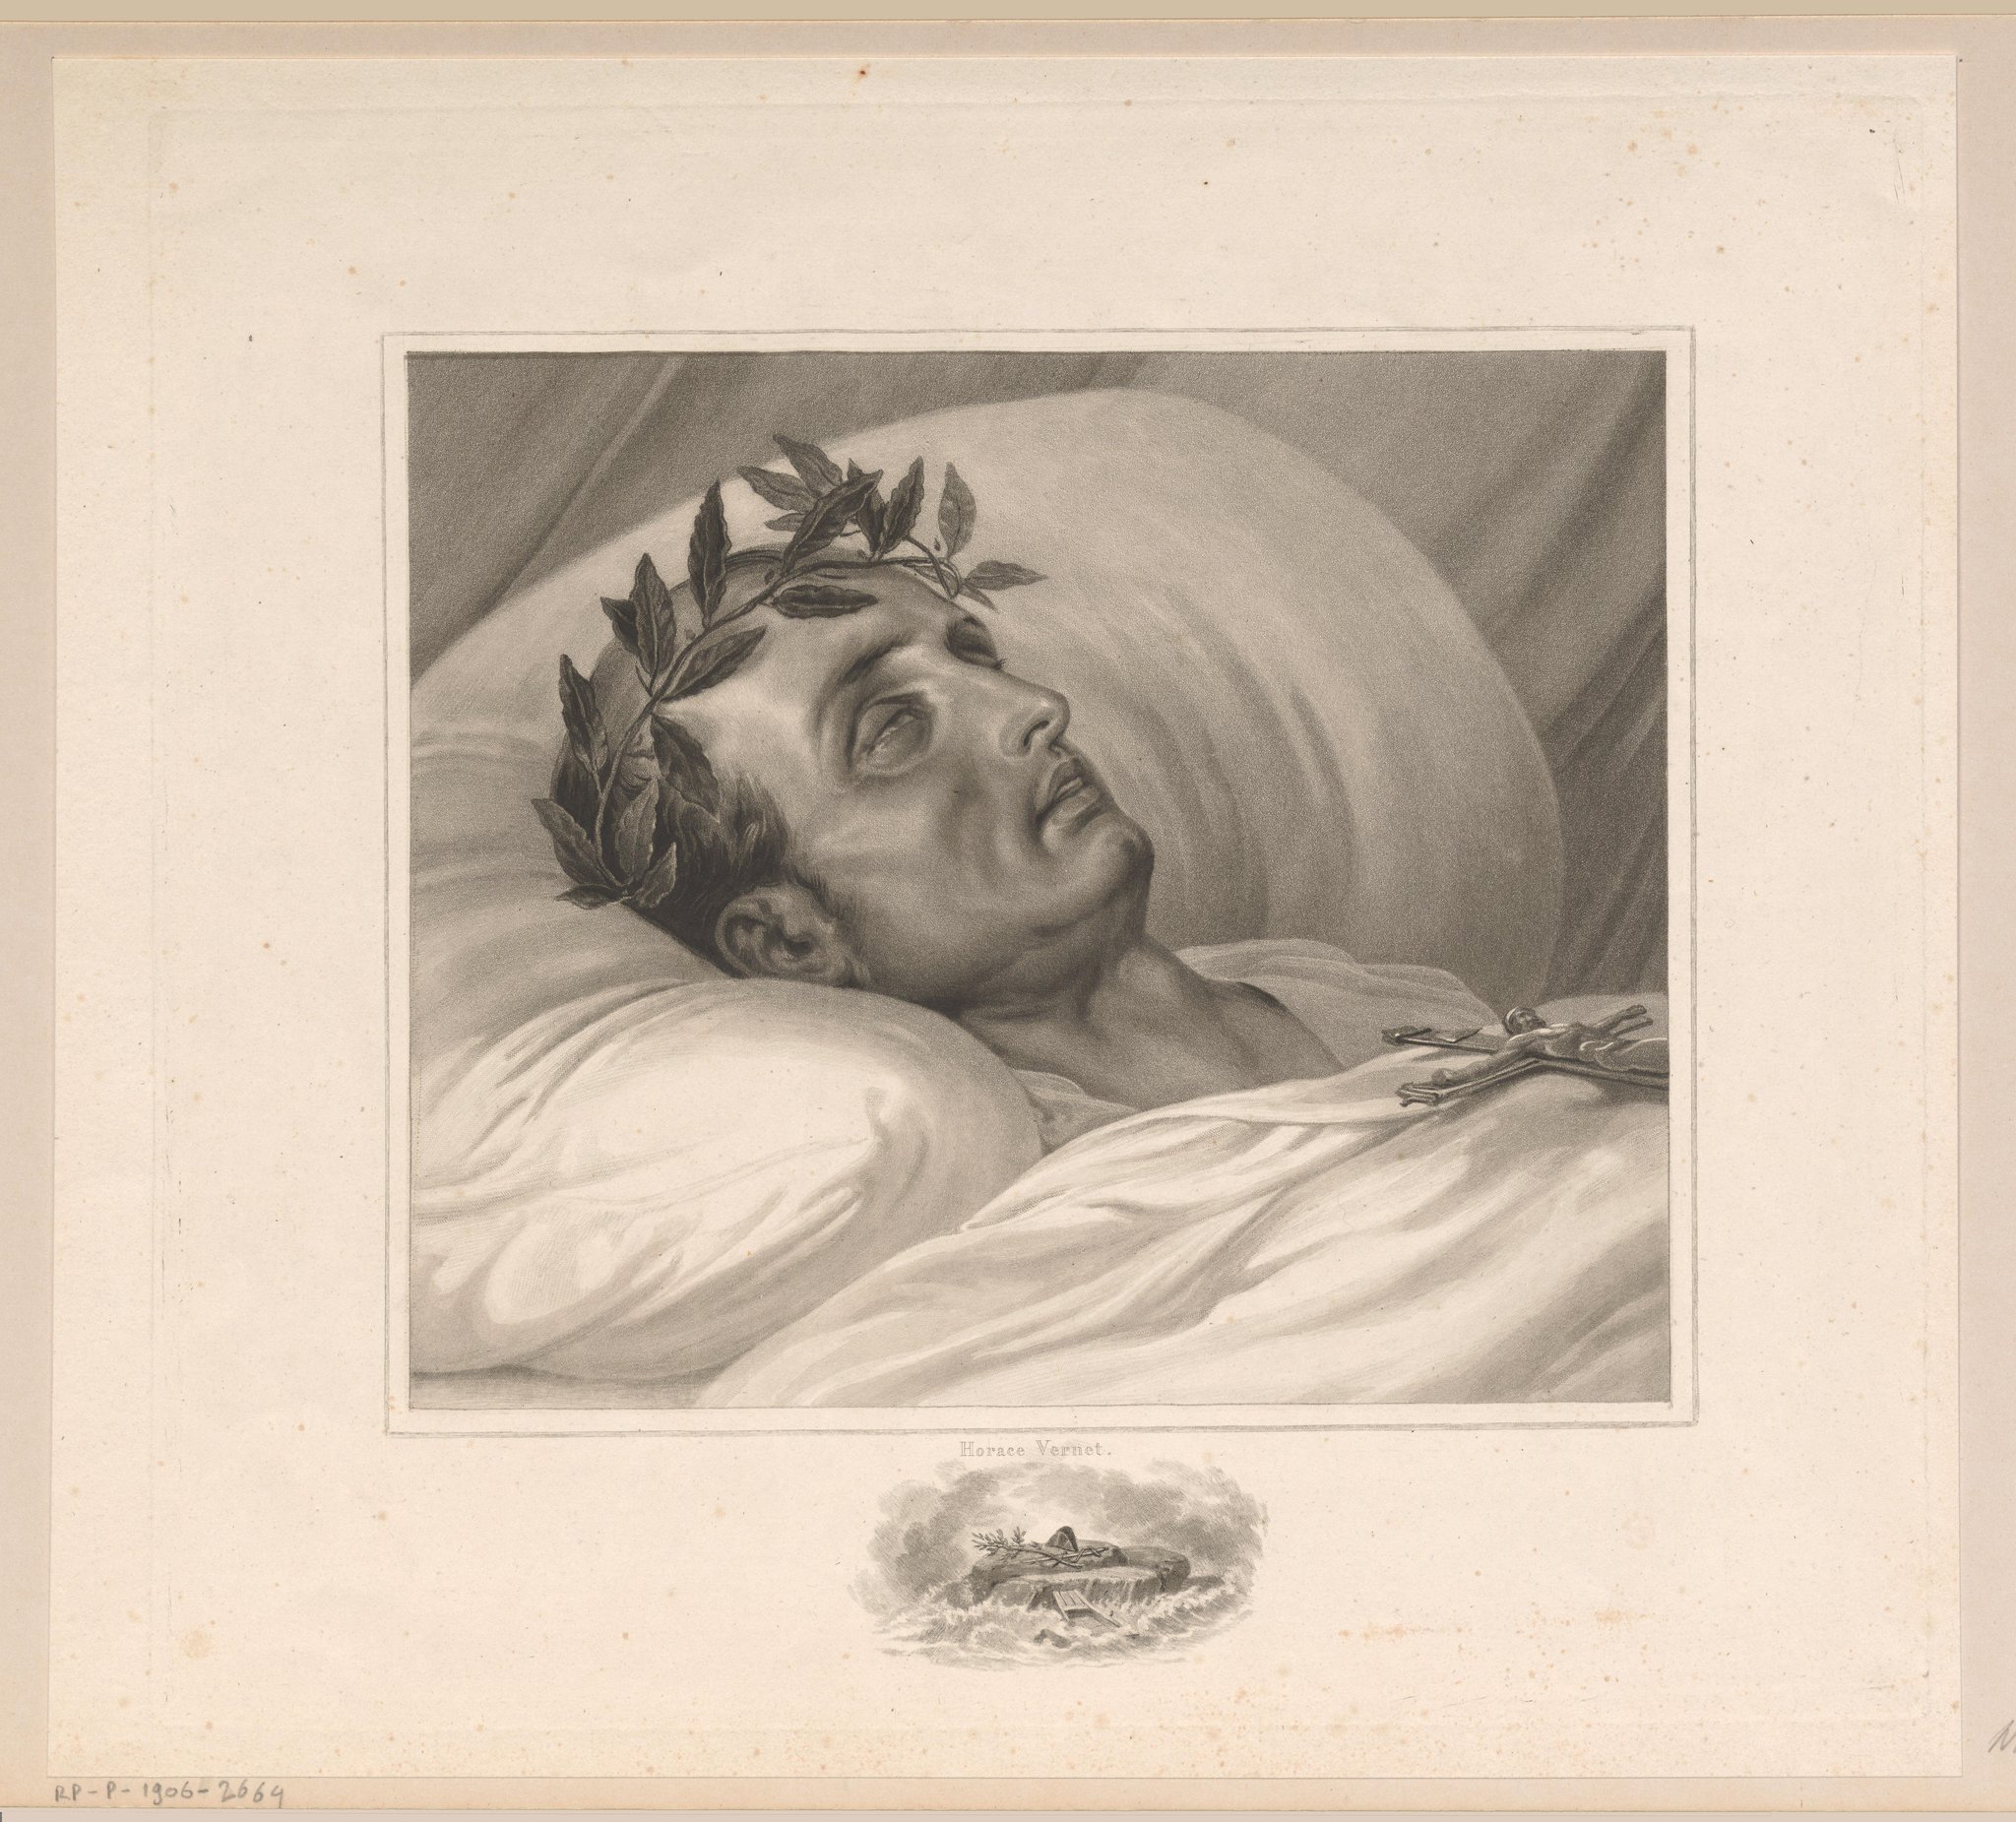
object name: print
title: Portret van Napoleon I Bonaparte op zijn doodsbed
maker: horace vernet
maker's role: draughtsman, painter, print maker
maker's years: 1789-1863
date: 1821-1863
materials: paper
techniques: aquatint, roulette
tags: napoleon i (emperor of the french), deathbed, historical persons, emperor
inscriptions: collector's mark: Lugt 2228